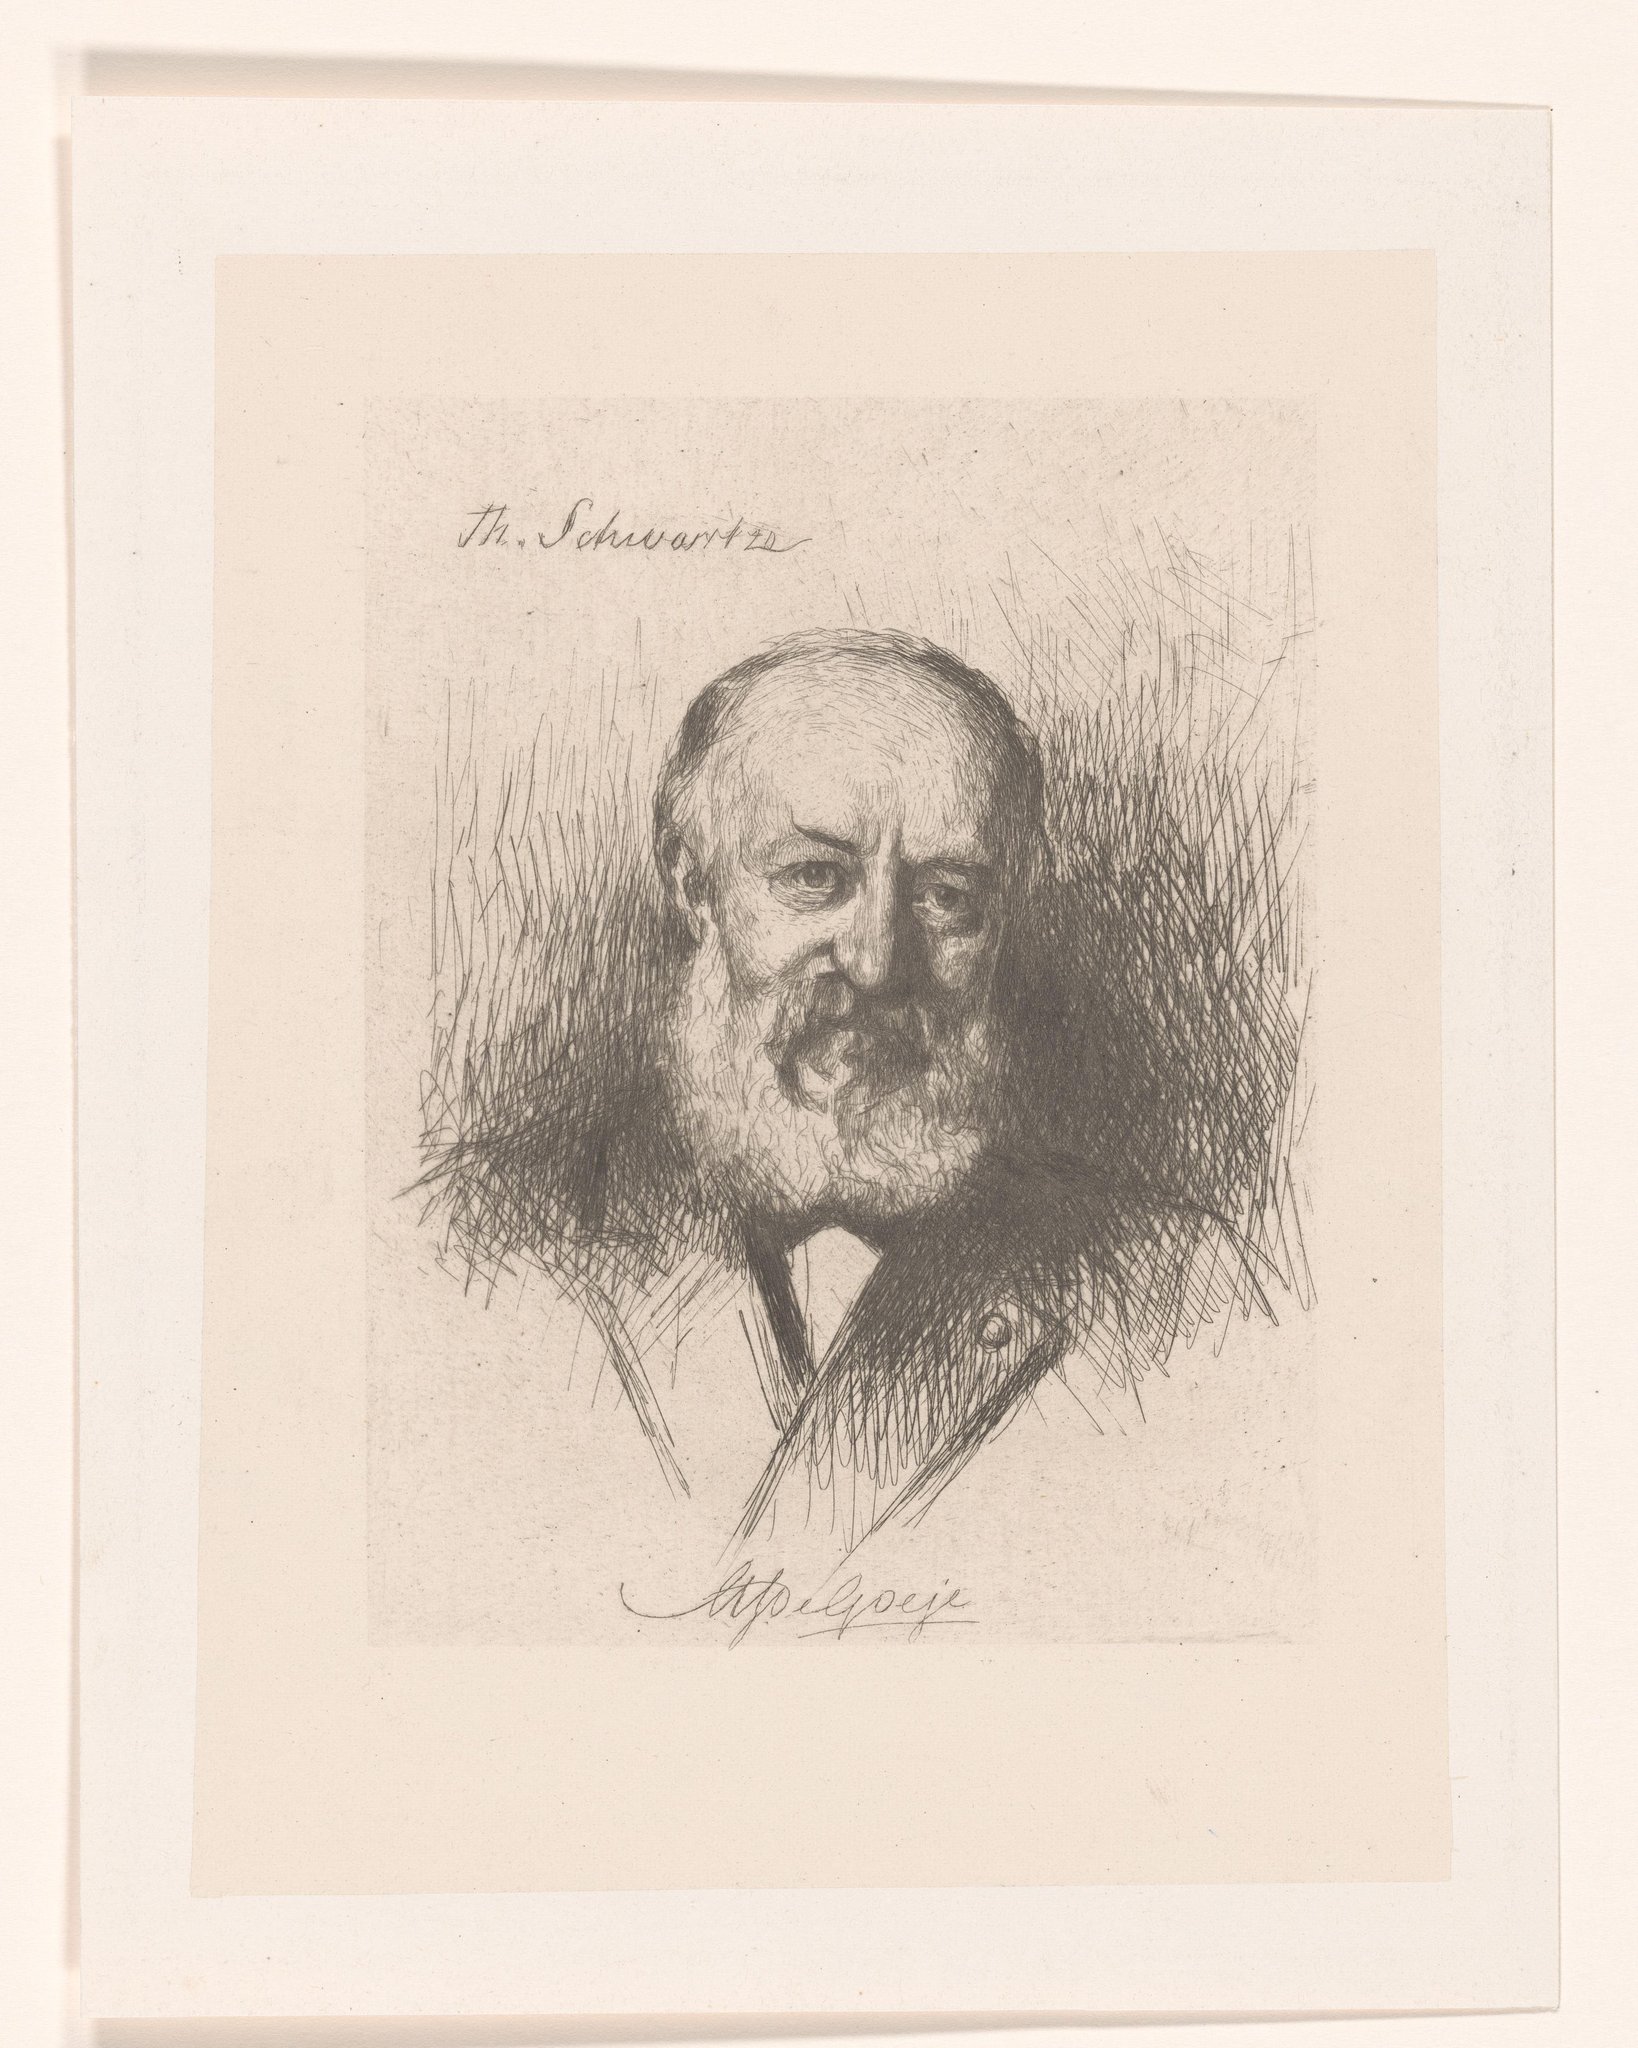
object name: print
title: Portret van professor de Gaige de Leyde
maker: thérèse schwartze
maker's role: draughtsman, painter, print maker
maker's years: 1851-1918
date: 1861-1918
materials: paper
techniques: etching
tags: historical persons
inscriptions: collector's mark: Lugt 2228